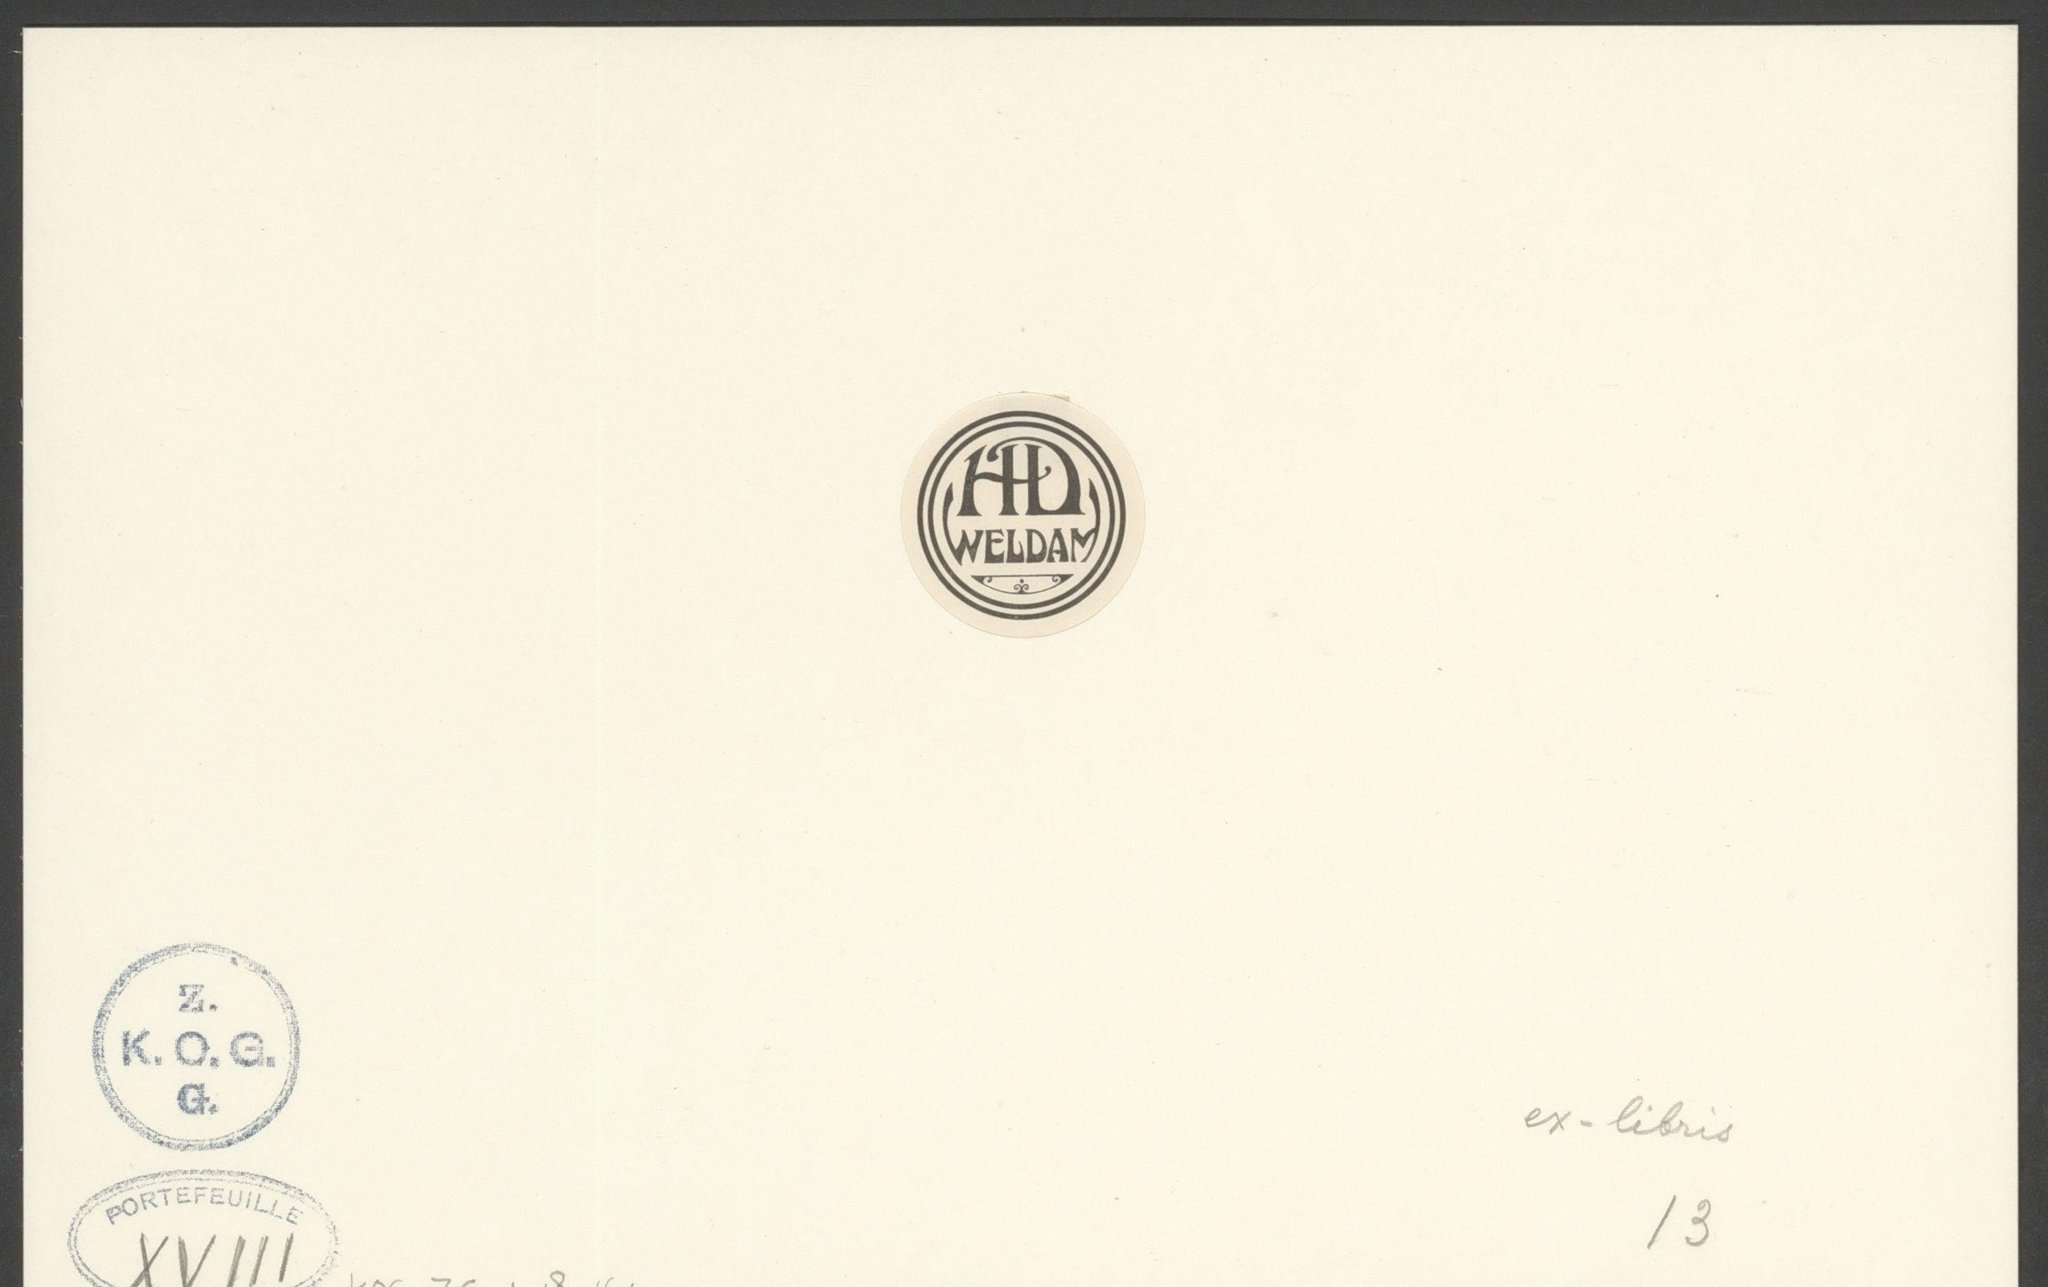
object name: bookplate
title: Ex libris van H.D. Weldam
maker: Anonymous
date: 1893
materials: paper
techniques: printing block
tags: ex-libris, letter combinations such as letterword, anagram, letter square, monogram, etc.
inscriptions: stamp, collector's mark: Lugt 1641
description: Onderwerpsrubrieken binnen de Atlas Zeden en Gewoonten: Schoone kunsten, Ex-libris en gelegenheidsgrafiek.